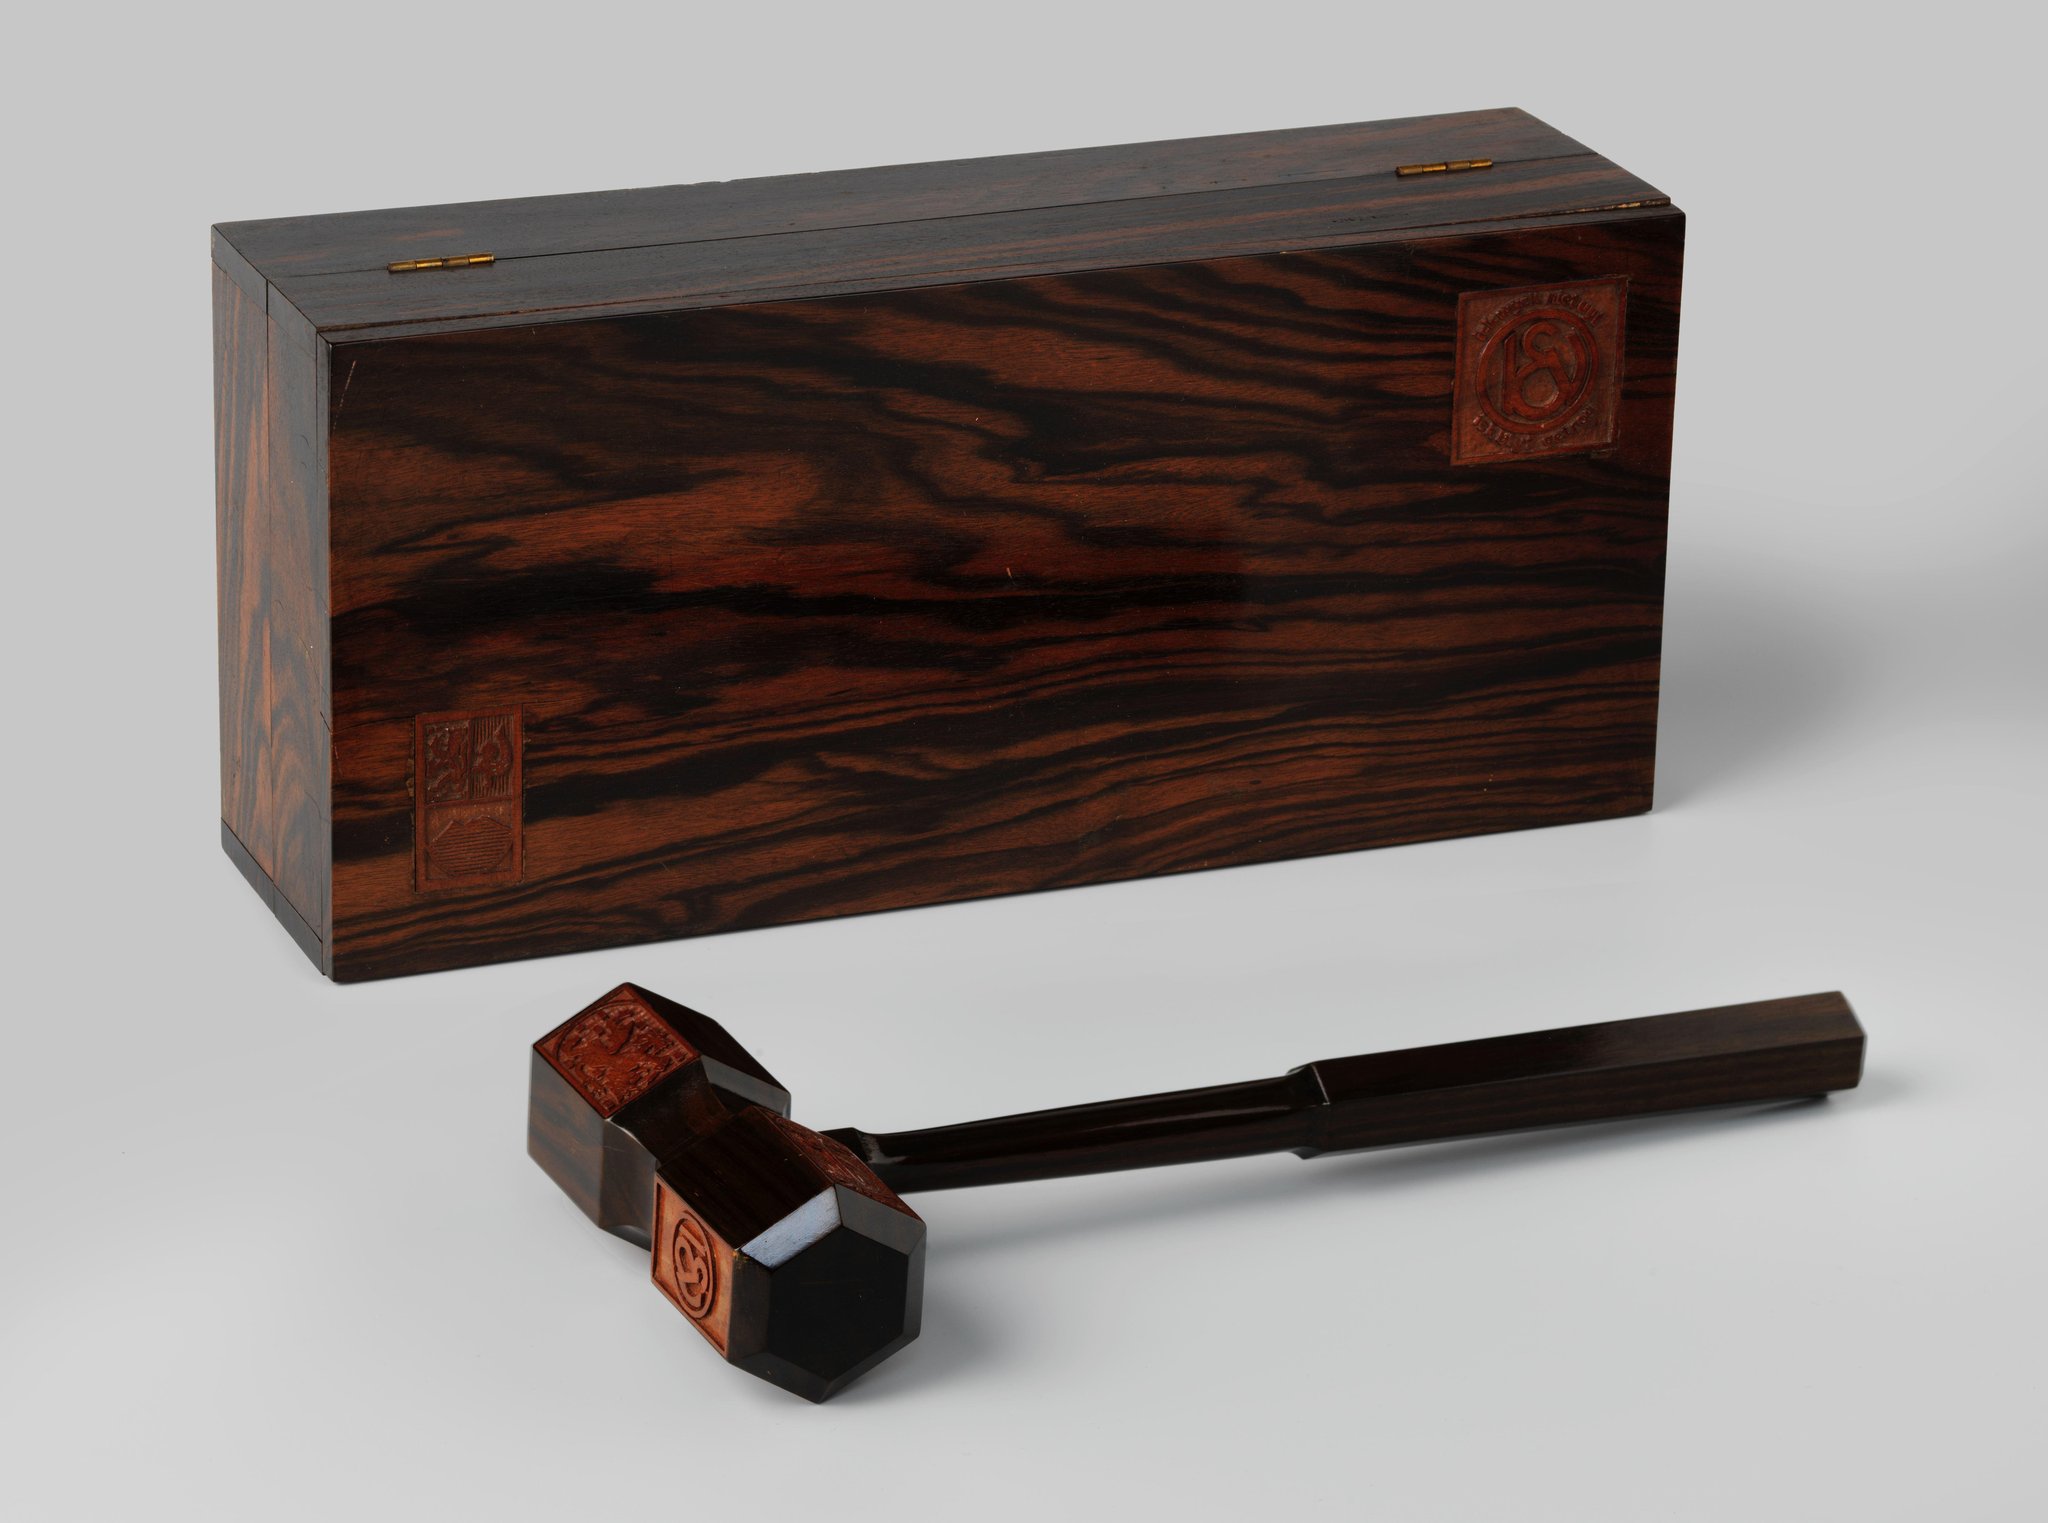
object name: persoonlijk object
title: Voorzittershamer(A) in rechthoekige kist (B) van coromandelhout, ingelegd met een lichtere houtsoort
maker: Anonymous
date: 1920-1930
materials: wood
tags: indo-europeesch verbond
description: Voorzittershamer in rechthoekig kistje (BK-1994-70-B) van coromandelhout en een lichtere houtsoort. De zeshoekige hamer heeft een ronde, zich verbredende steel met een lang, zeshoekig uiteinde. De zijden van de hamer verspringend ingelegd met lichter houten, verdiepte velden gesneden met het monogram IEV en met vijf wapens: Nederlandse leeuw, zwaard met lauwerkrans, krokodil en vis, palmboom met zwaard, bladerboom. Het scharnierende deksel van het kistje is ingelegd met lichter houten, verdiept veld met het monogram IEV in cirkel met randschrift: ick wyck niet uyt ik blyf getrou, en een soortgelijk veld met wapen. Afkomstig van het Indo-Europeesch Verbond. Nederlands-Indië, ca. 1920-1930.